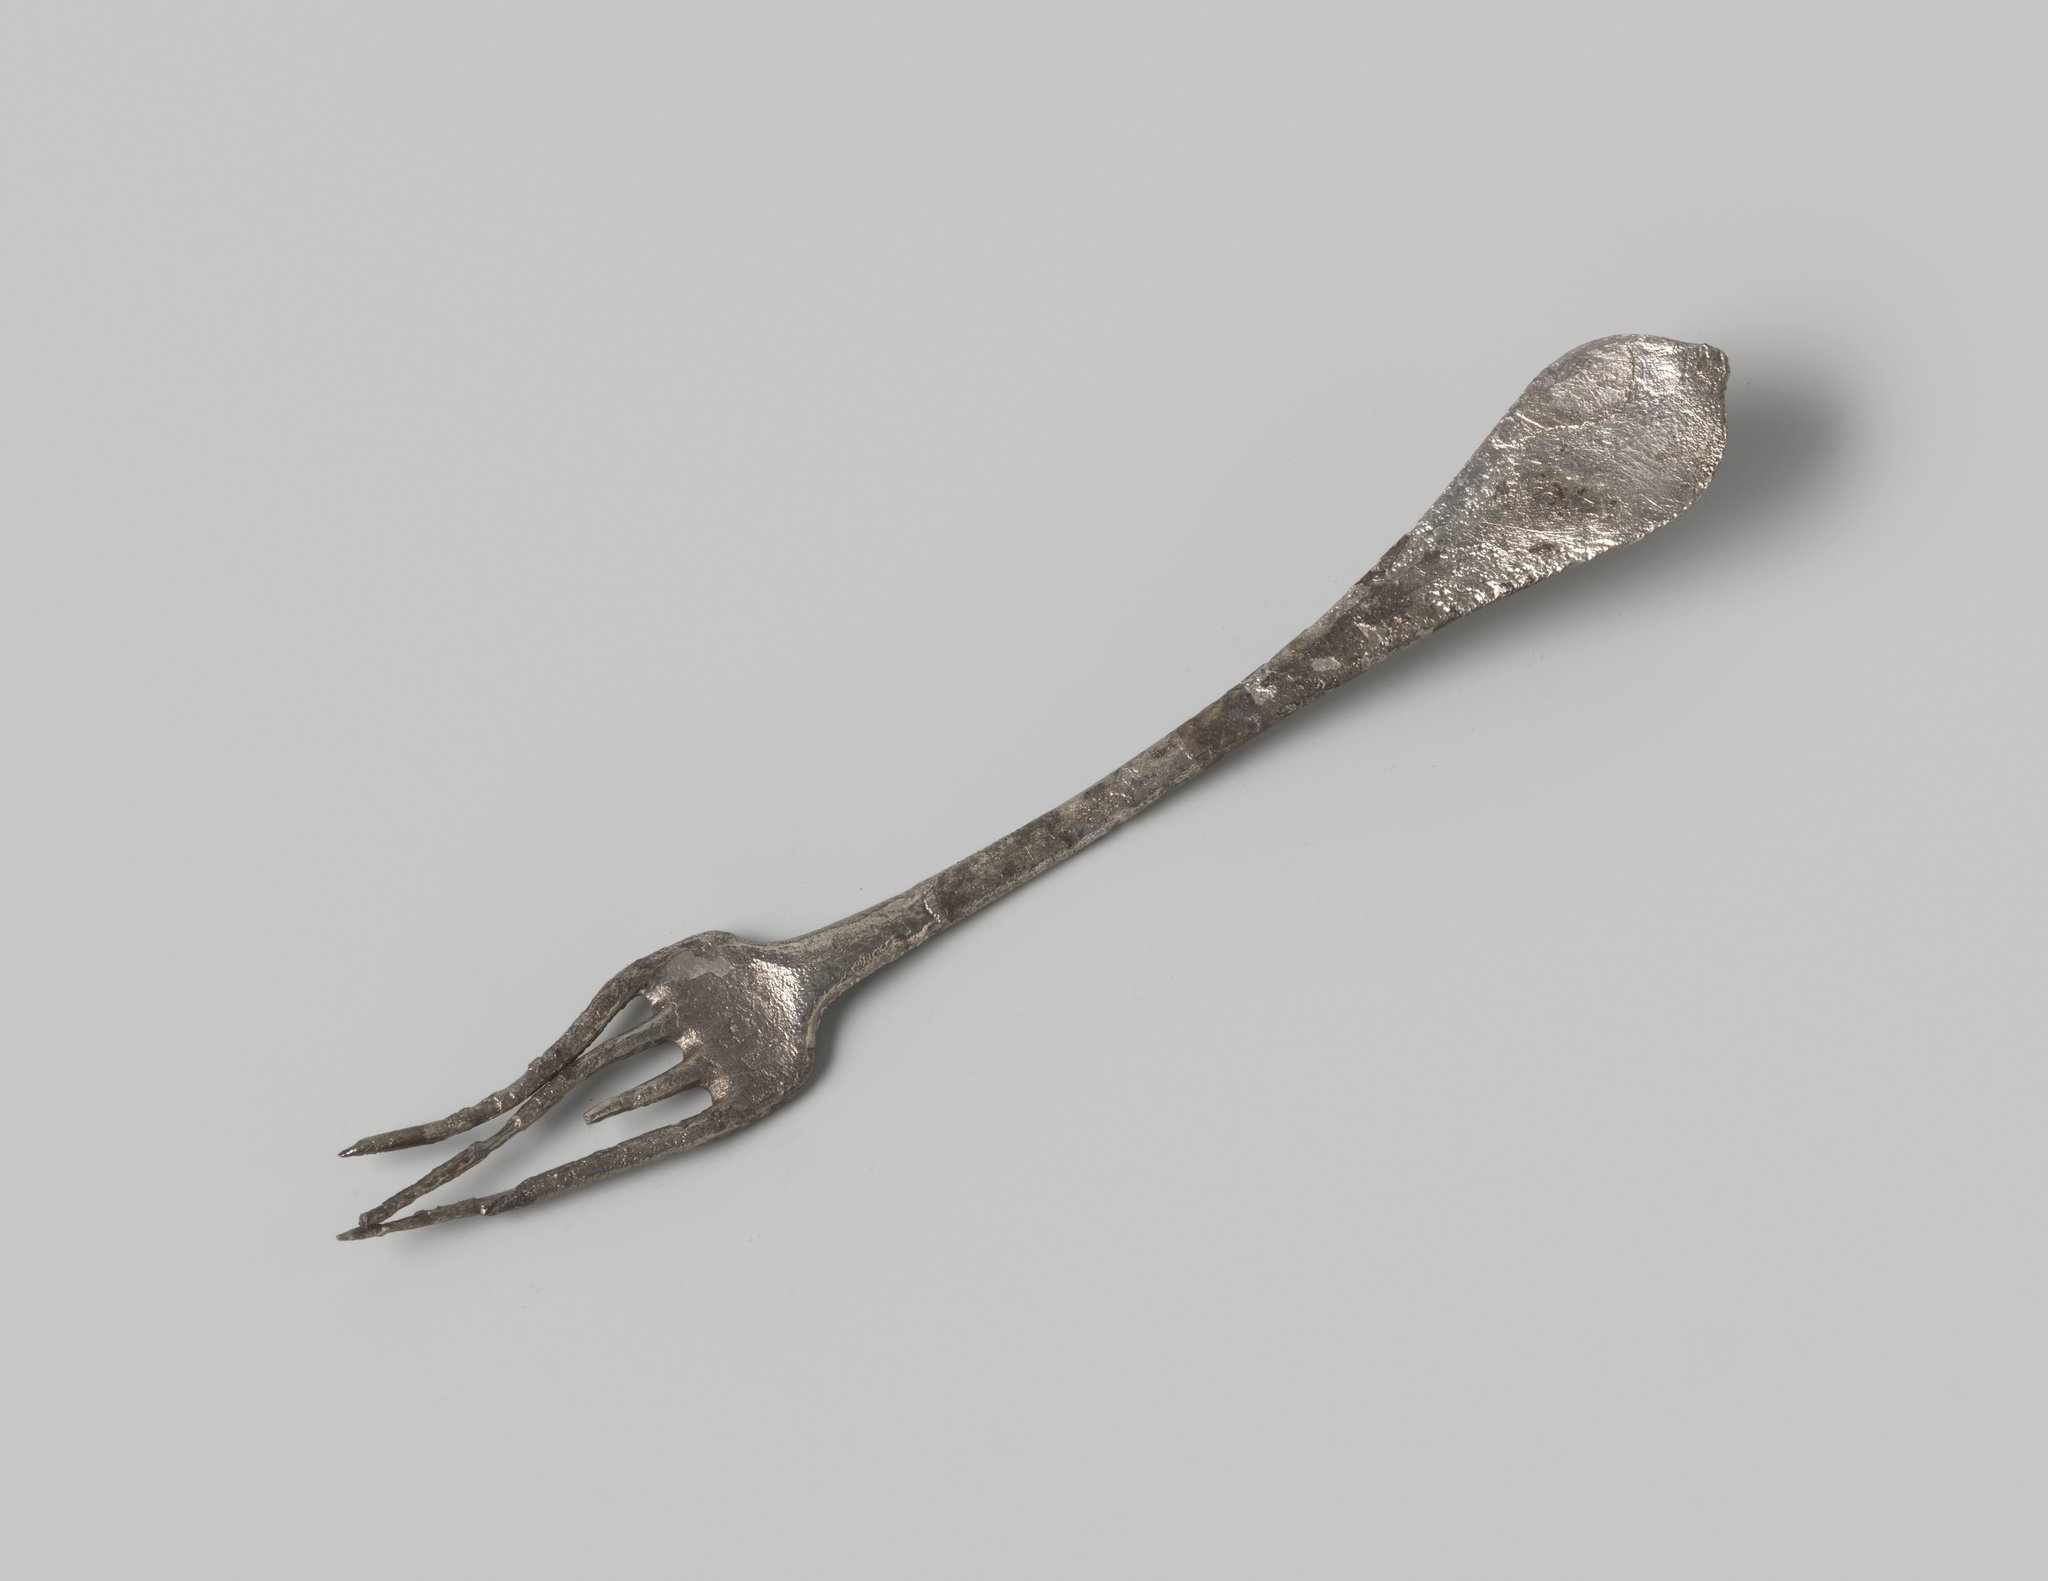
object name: fork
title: Vork uit het wrak van de Oost-Indiëvaarder Hollandia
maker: Anonymous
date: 1700-1743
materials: silver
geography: netherlands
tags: verenigde oostindische compagnie, hollandia (schip), annet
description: Cutlery, fork; 4 prongs, widening wavy-ended stem, oval in section, engraved crowned scrolling motif (monogram?) at upper end, 1 mark, illegible.